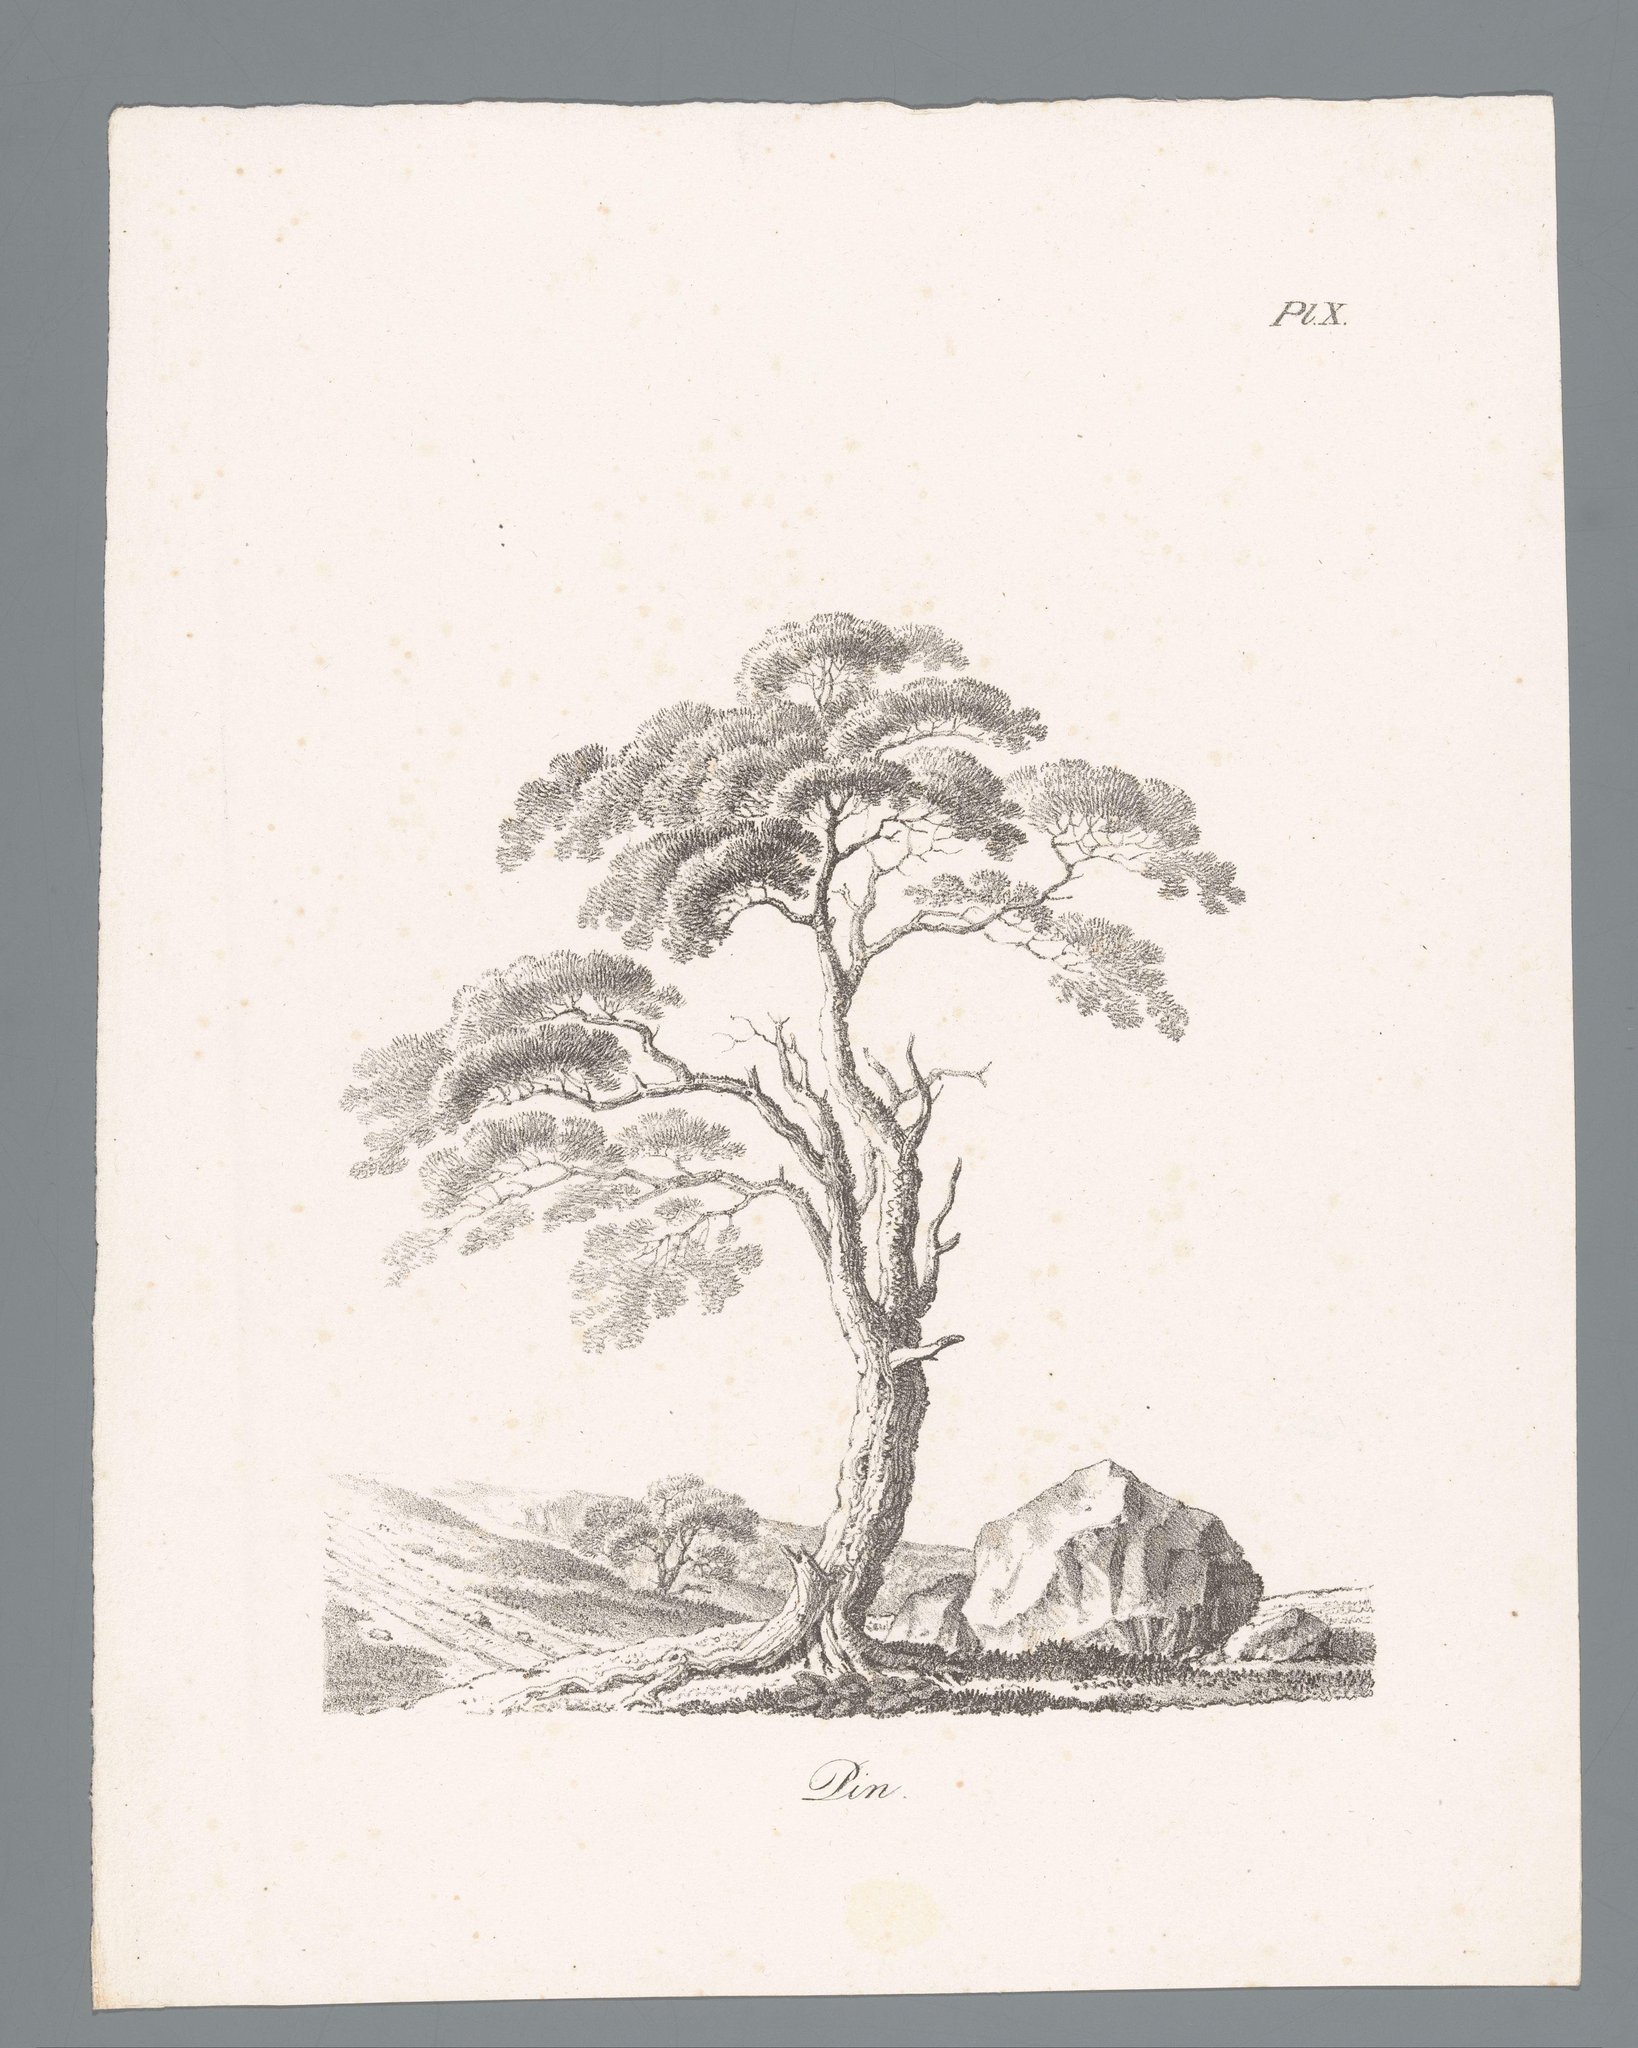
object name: print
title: Pin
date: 1820-1833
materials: paper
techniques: lithograph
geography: mulhouse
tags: trees: pine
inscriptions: collector's mark: Lugt 2228